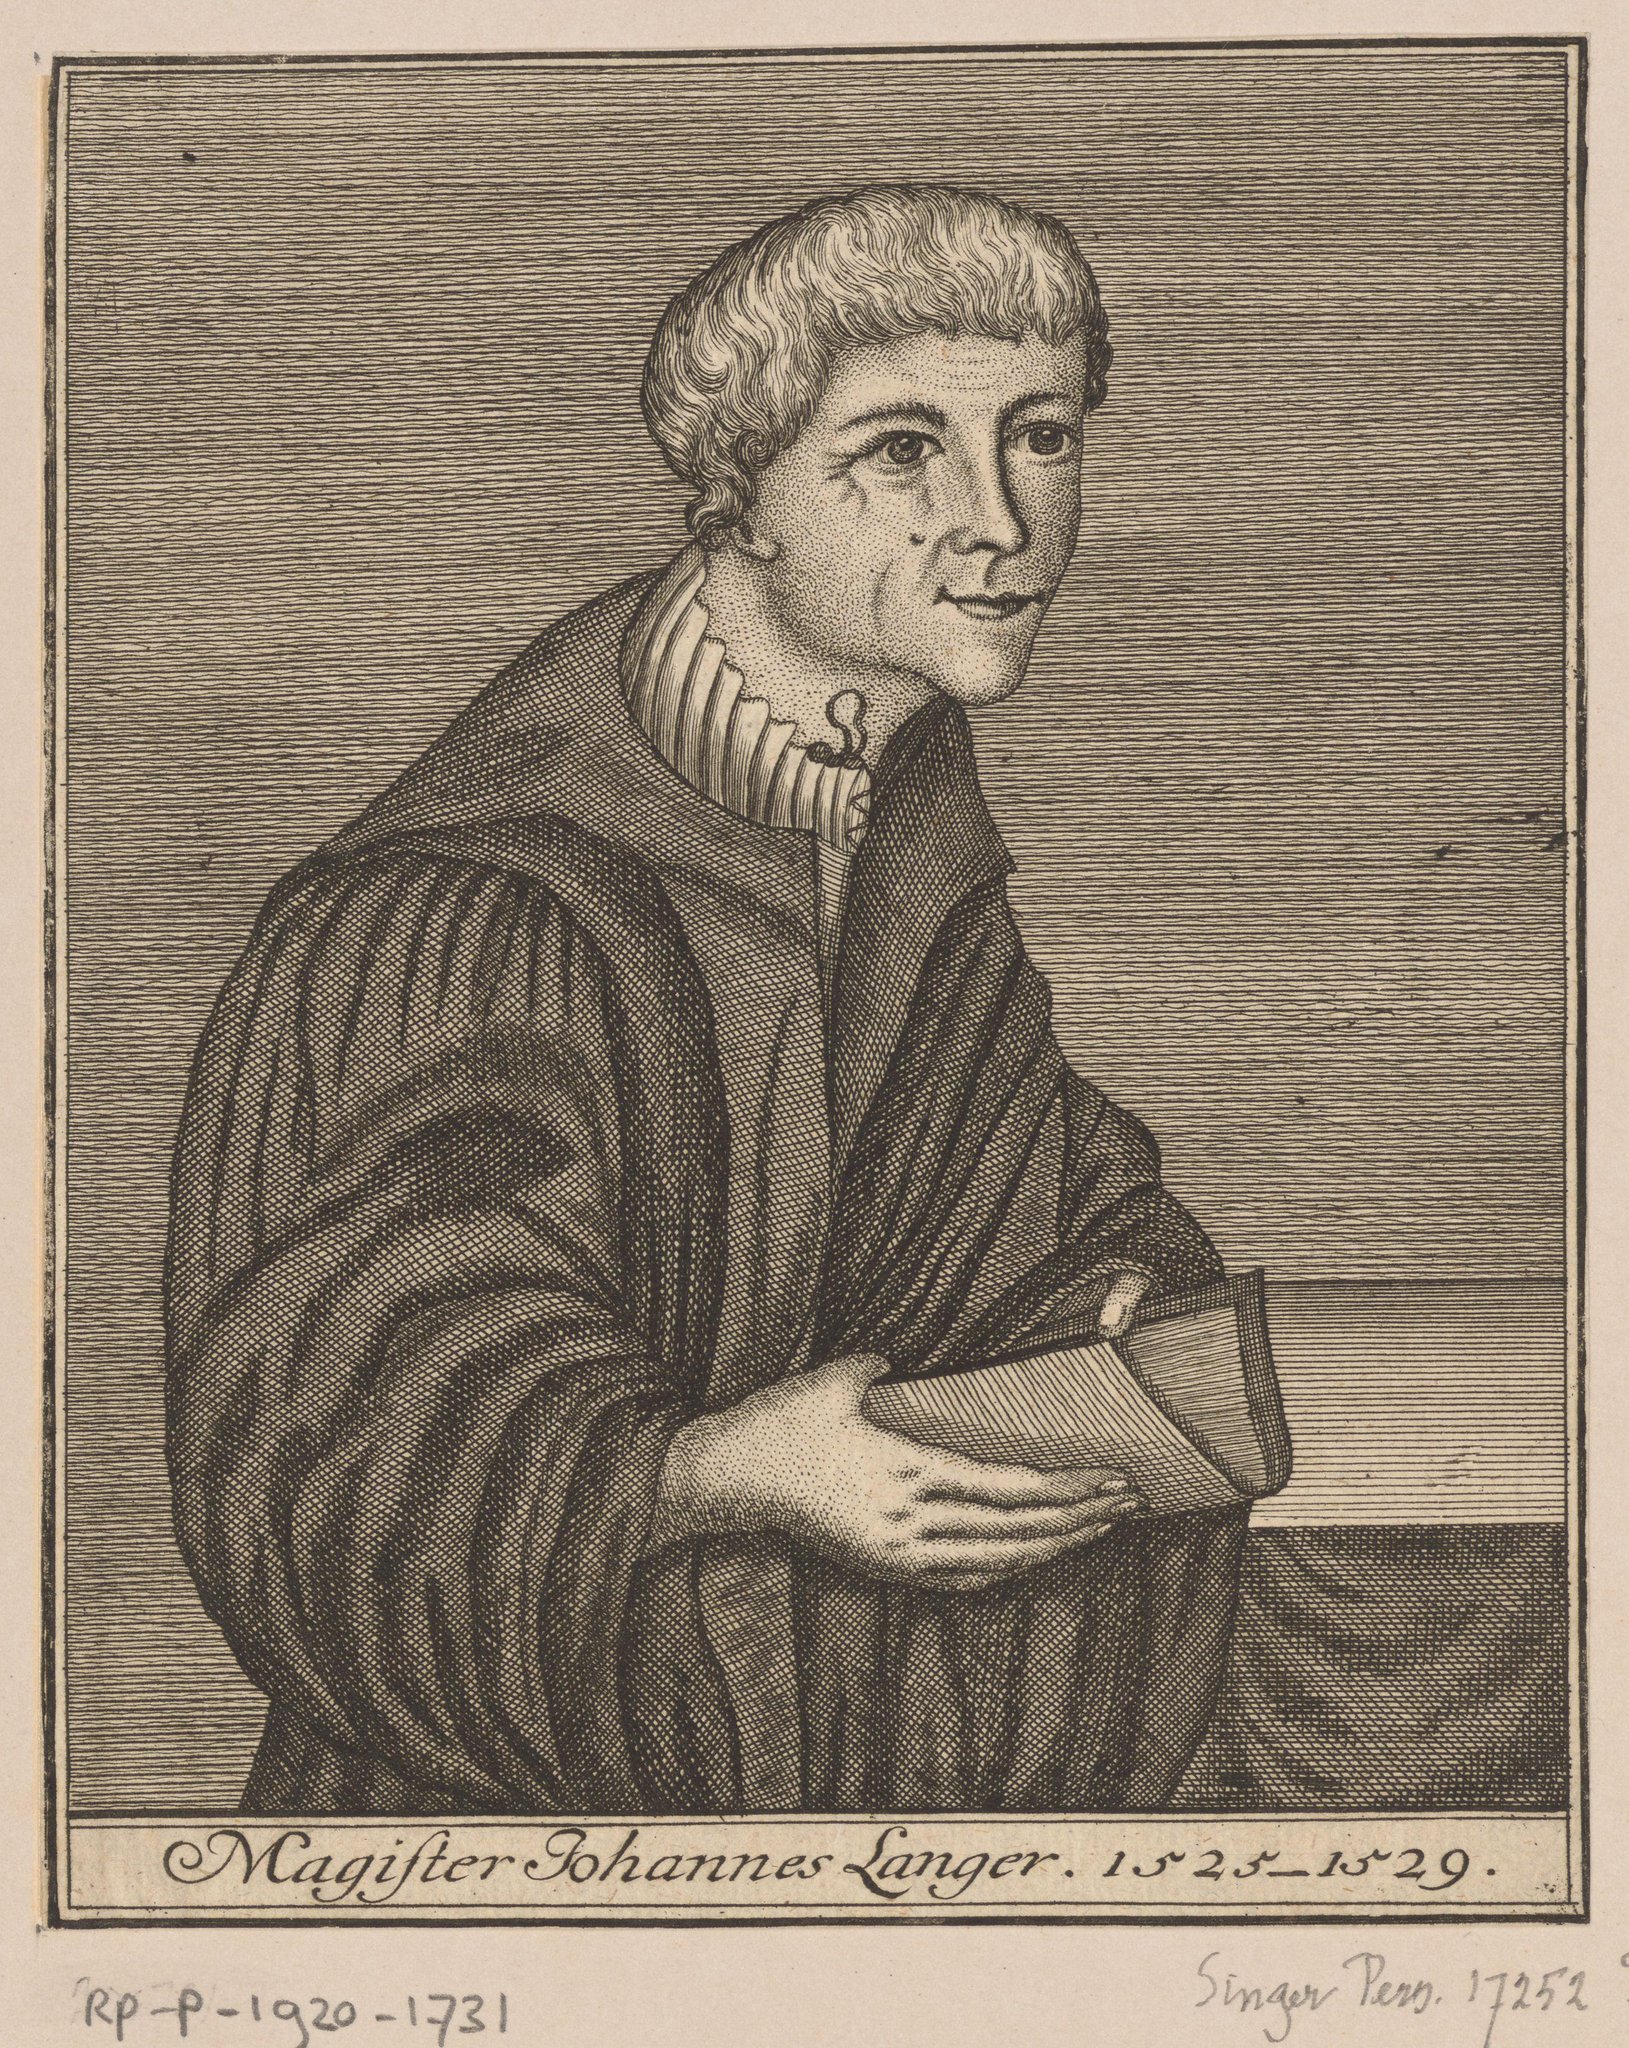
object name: print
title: Portret van Johannes Langer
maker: Anonymous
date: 1650-1750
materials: paper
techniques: engraving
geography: germany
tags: theologian, historical persons, book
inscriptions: collector's mark: Lugt 2228